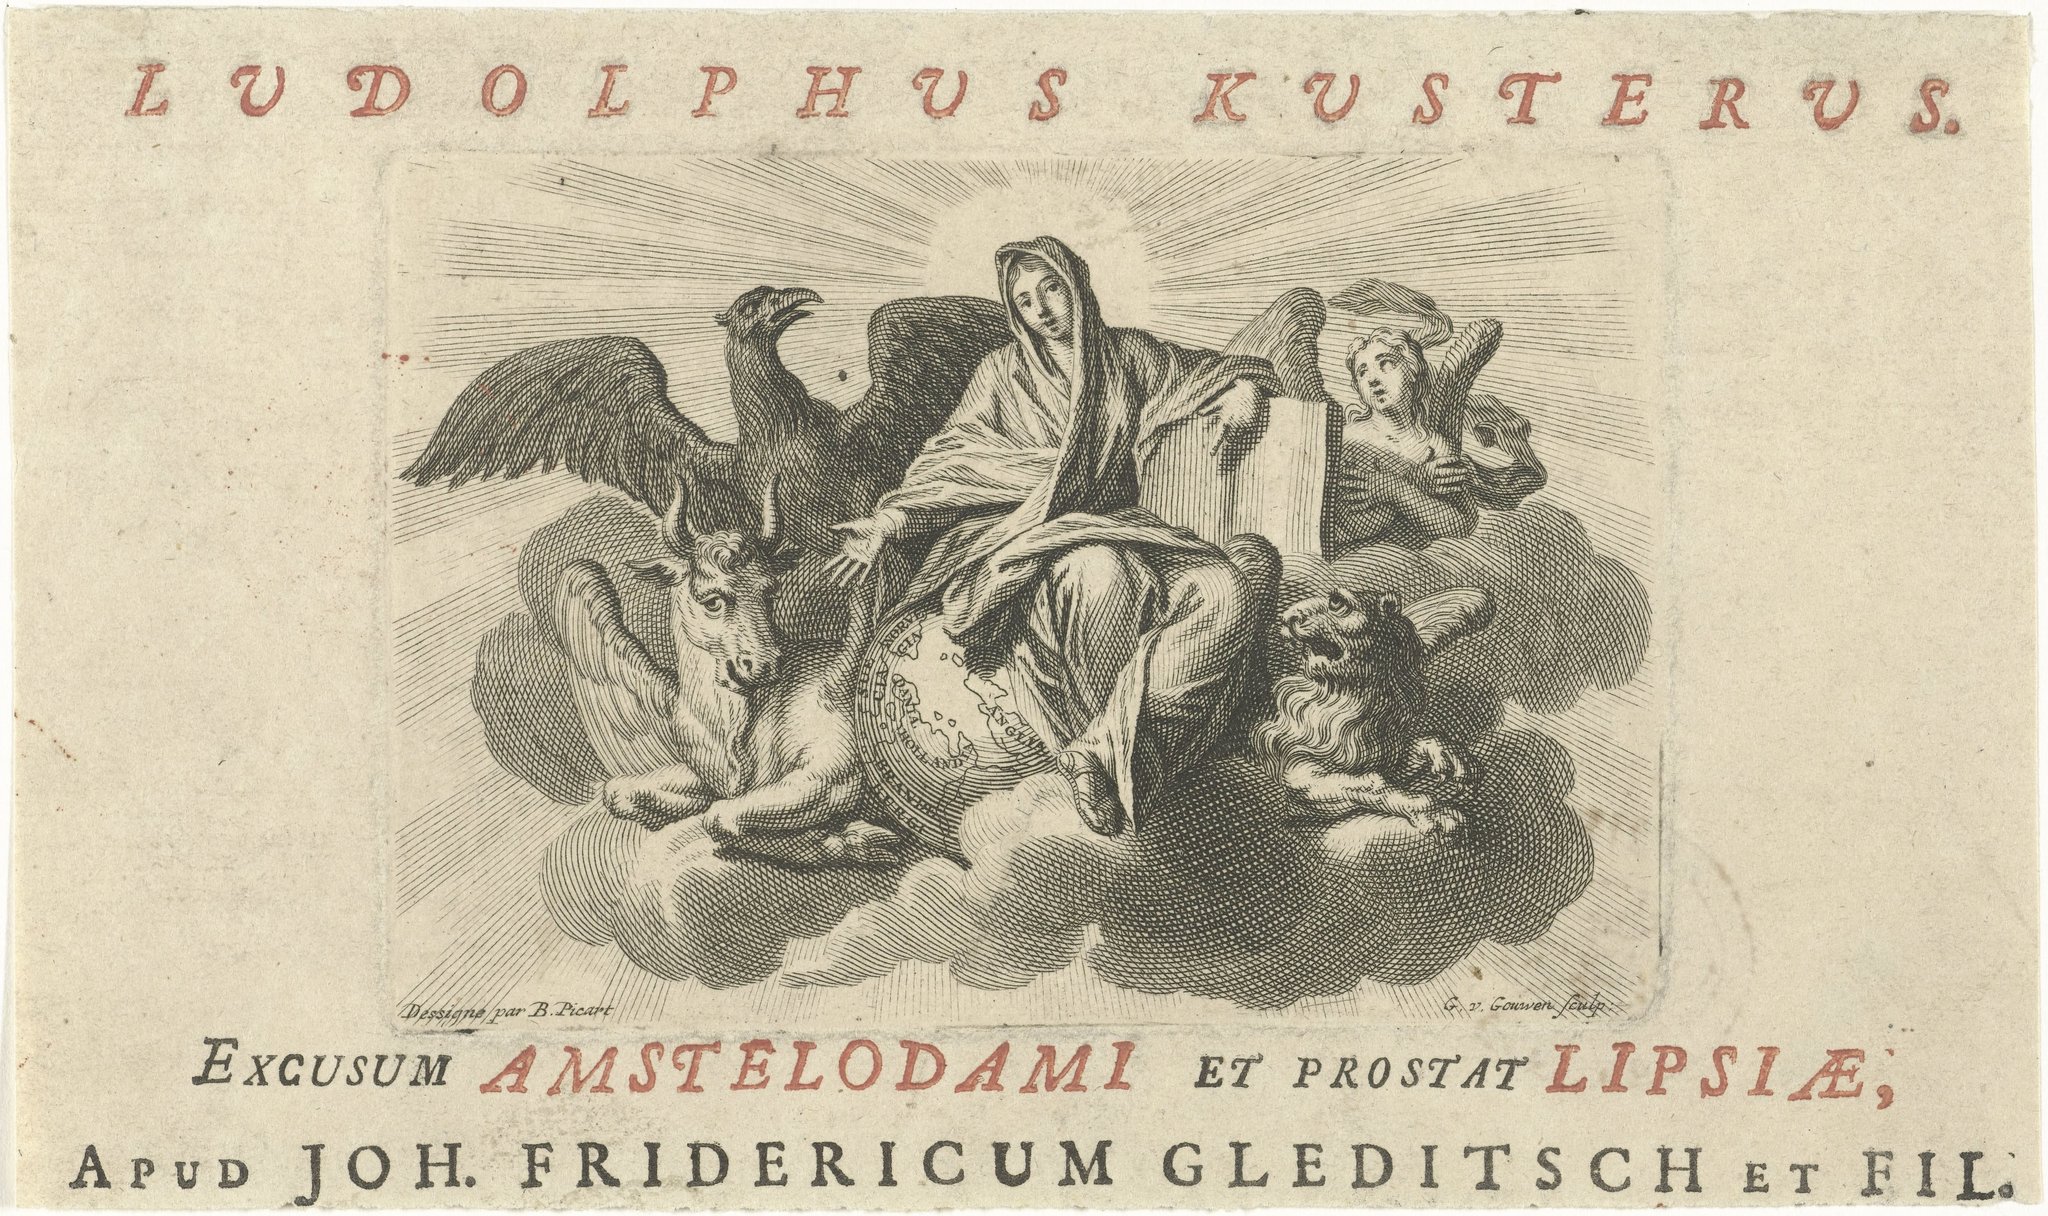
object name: titelblad, titelpagina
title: Maria en de vier apocalyptische dieren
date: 1723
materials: paper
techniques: engraving, letterpress printing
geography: amsterdam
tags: the four symbols of the evangelists, 'the apocalyptic beasts' (+ mary)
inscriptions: collector's mark: Lugt 240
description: Titelpagina met in het midden Maria zittend op een wereldbol in de wolken. Rondom haar de vier apocalyptische dieren.